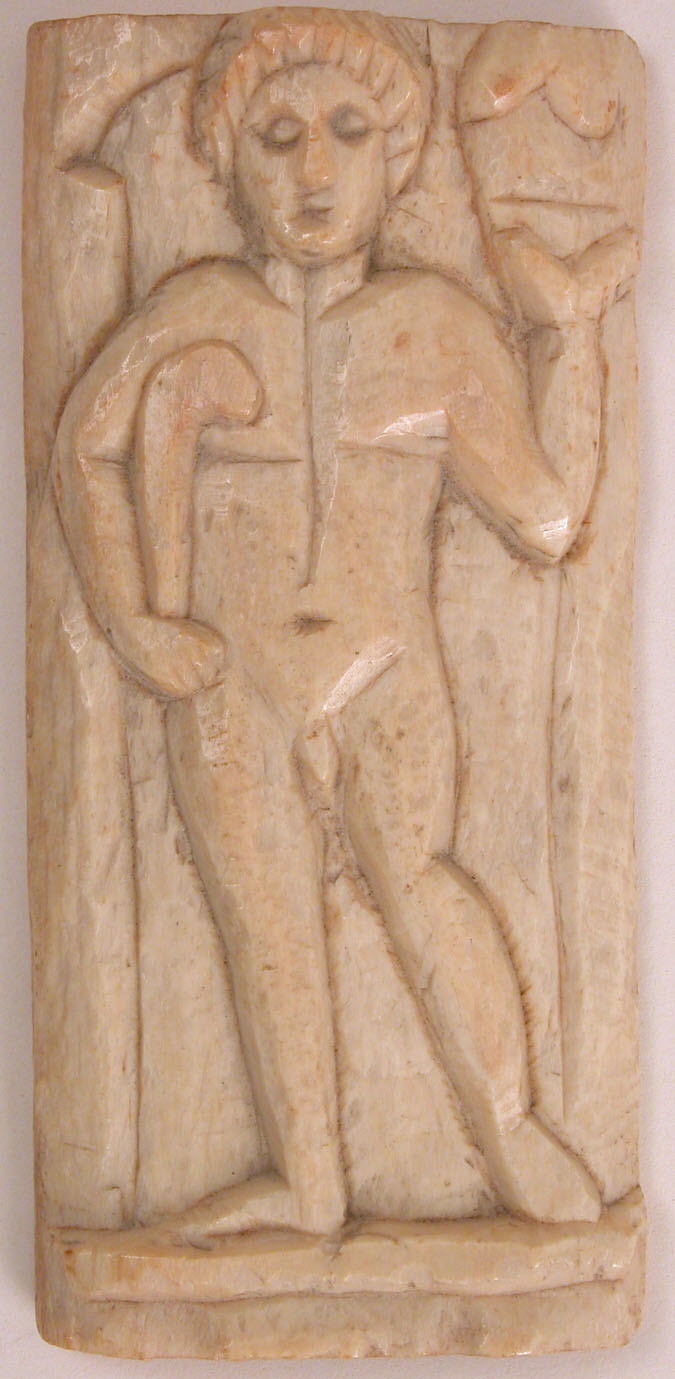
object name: plaque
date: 401-800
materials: bone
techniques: carving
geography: palestine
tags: male nudes